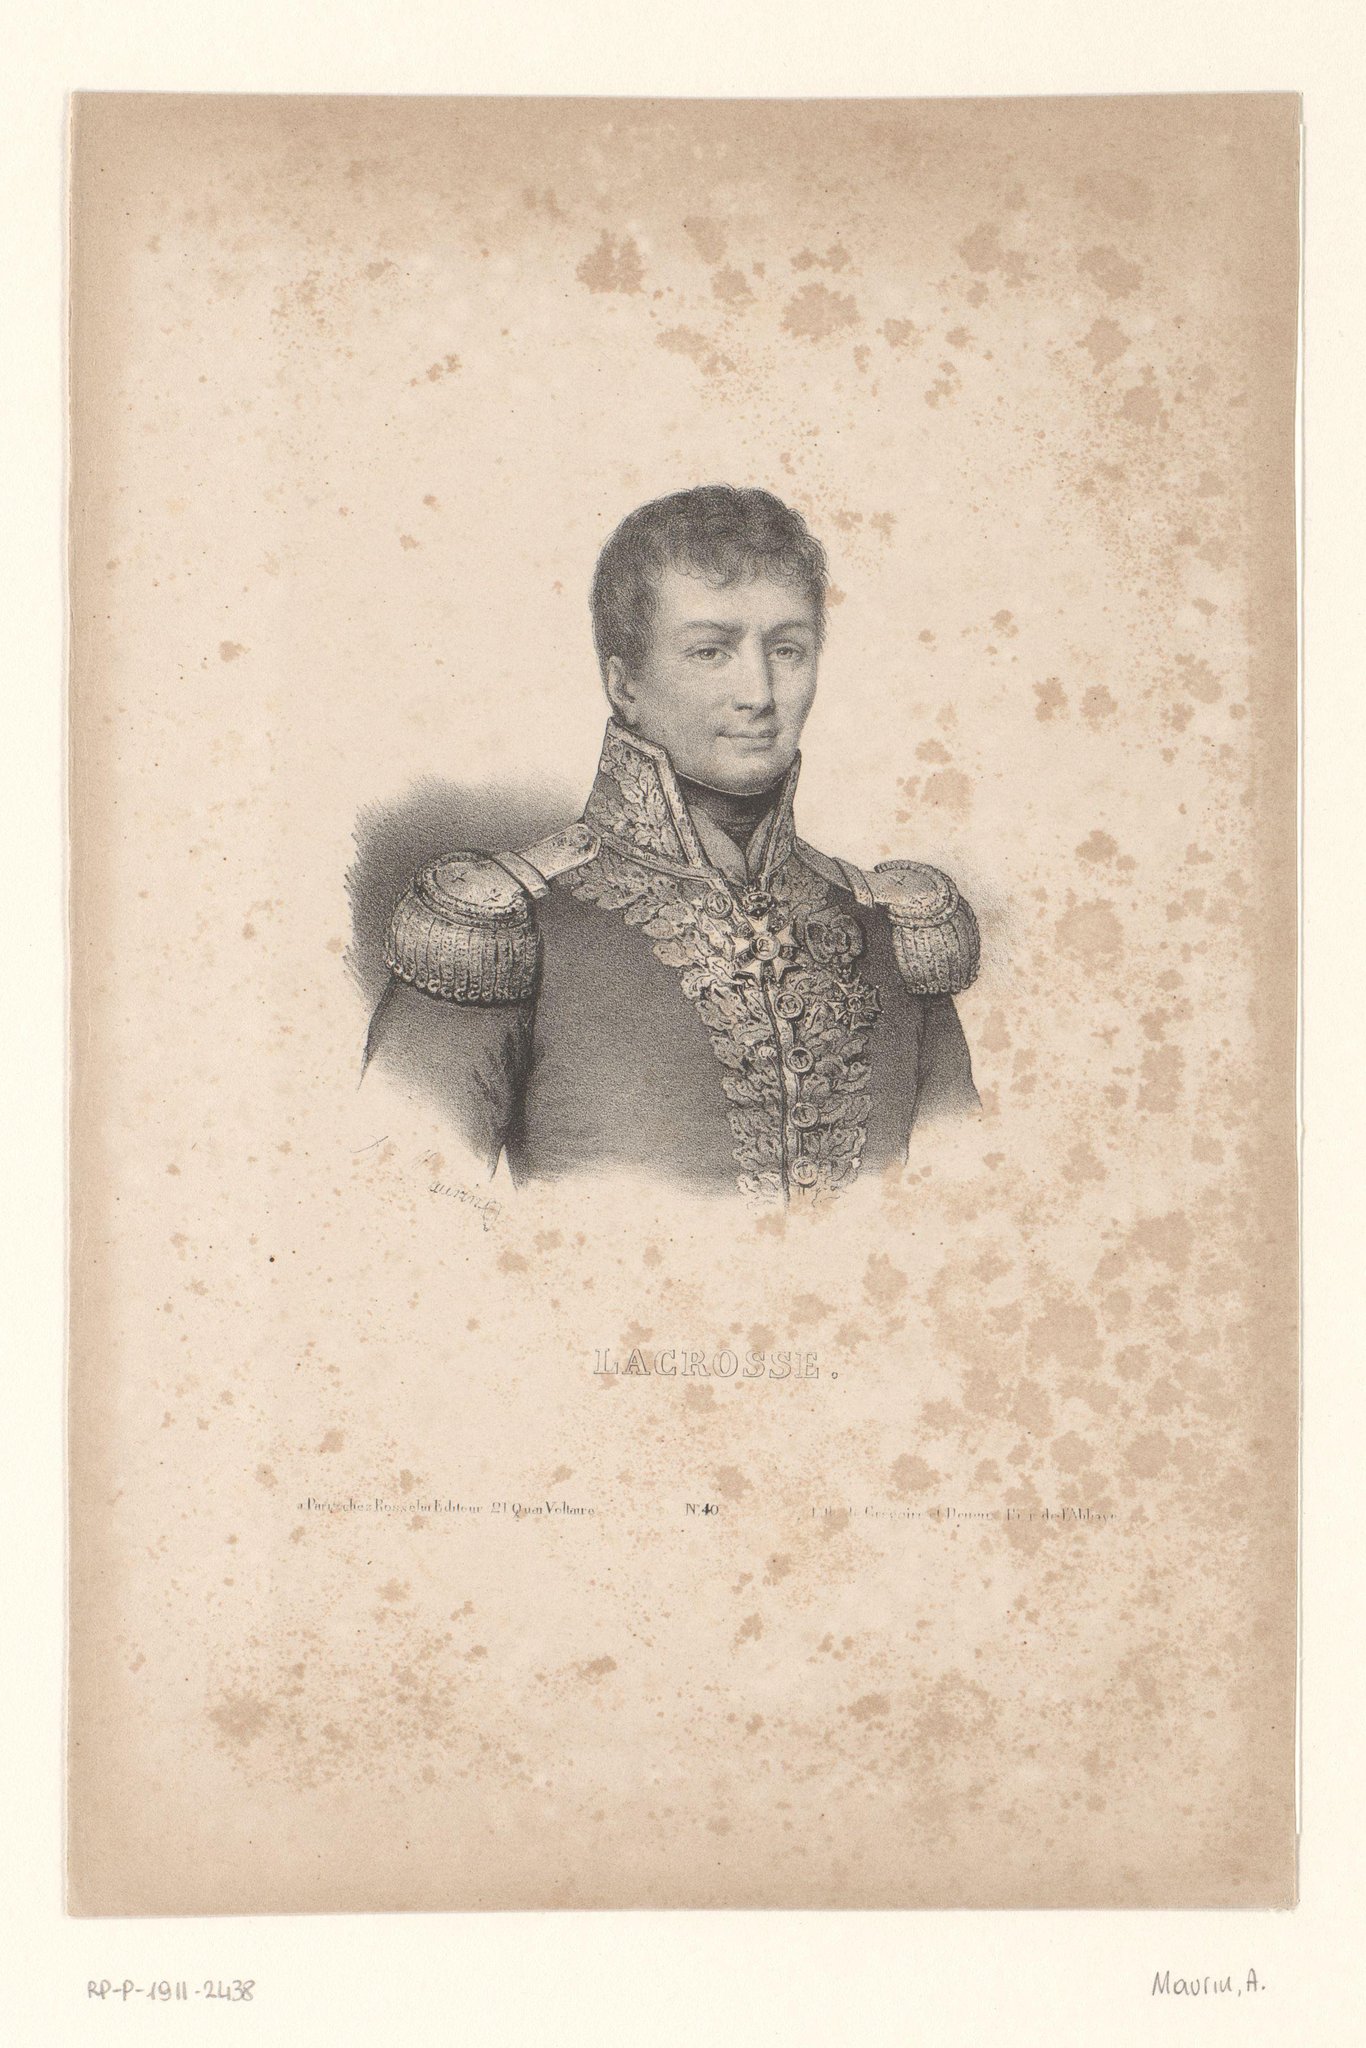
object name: print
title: Portret van Jean-Baptiste Raymond de Lacrosse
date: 1836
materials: paper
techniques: lithograph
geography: paris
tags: naval officer, historical persons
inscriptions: collector's mark: Lugt 2228